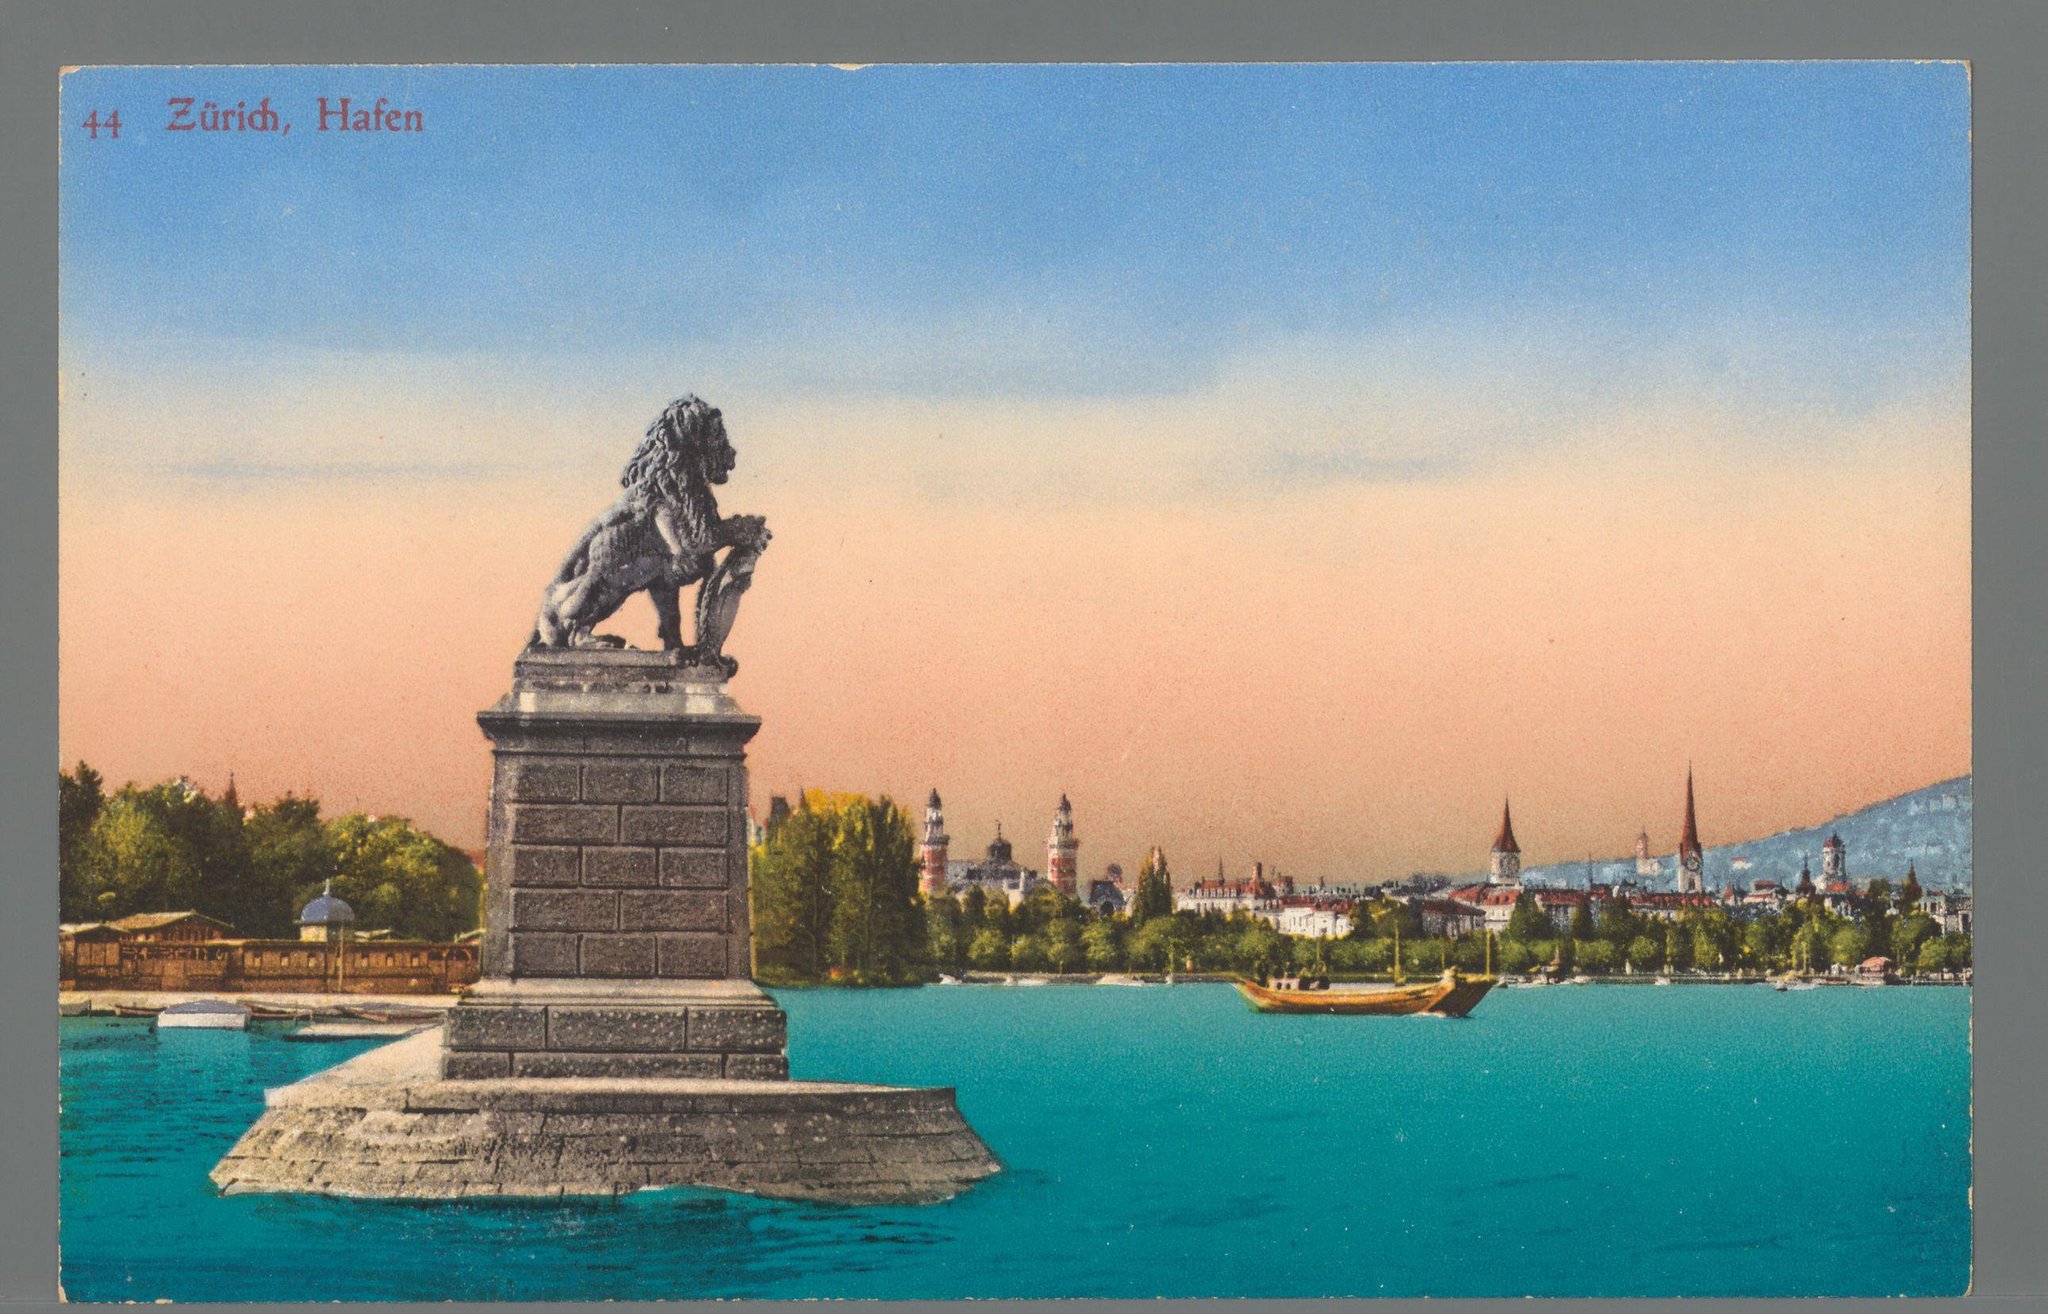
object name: photomechanical print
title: Zürich, Hafen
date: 1913-1920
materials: cardboard, photographic process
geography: zurich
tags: harbour, monument, statue, prospect of city, town panorama, silhouette of city